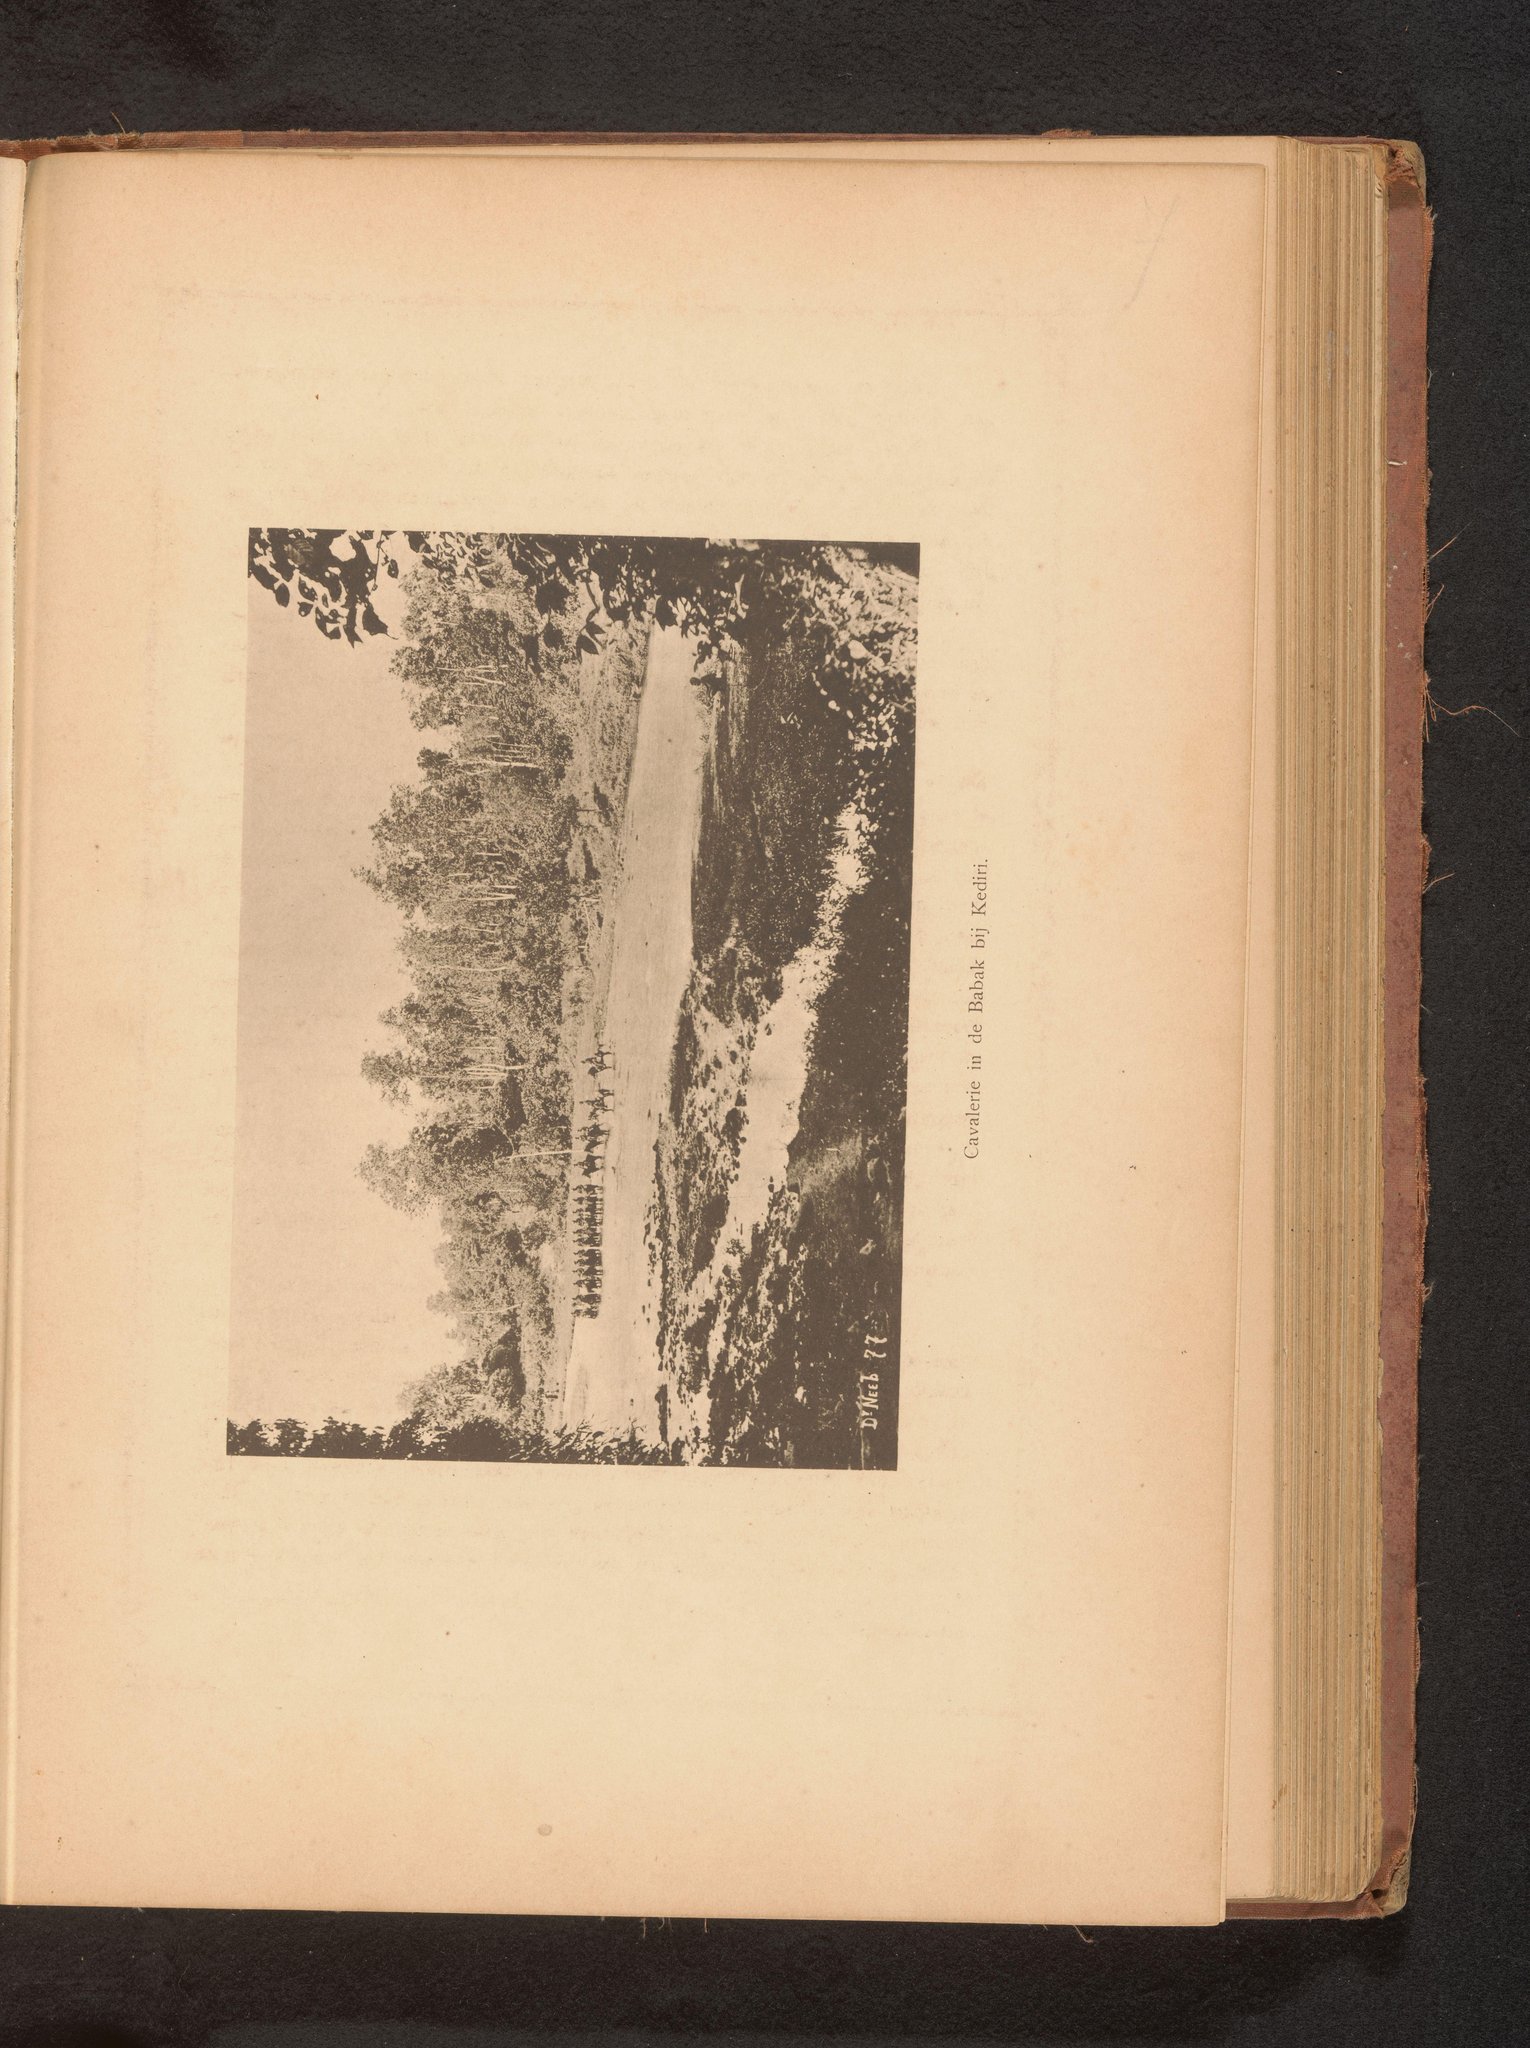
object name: page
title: Gezicht op de cavalerie in een rivier bij Kediri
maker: christiaan johan neeb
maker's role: arts, fotograaf, officier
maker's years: 1860-1925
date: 1892-1897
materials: paper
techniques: photograph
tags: land forces (+ cavalry, horsemen), trees, river, indonesia